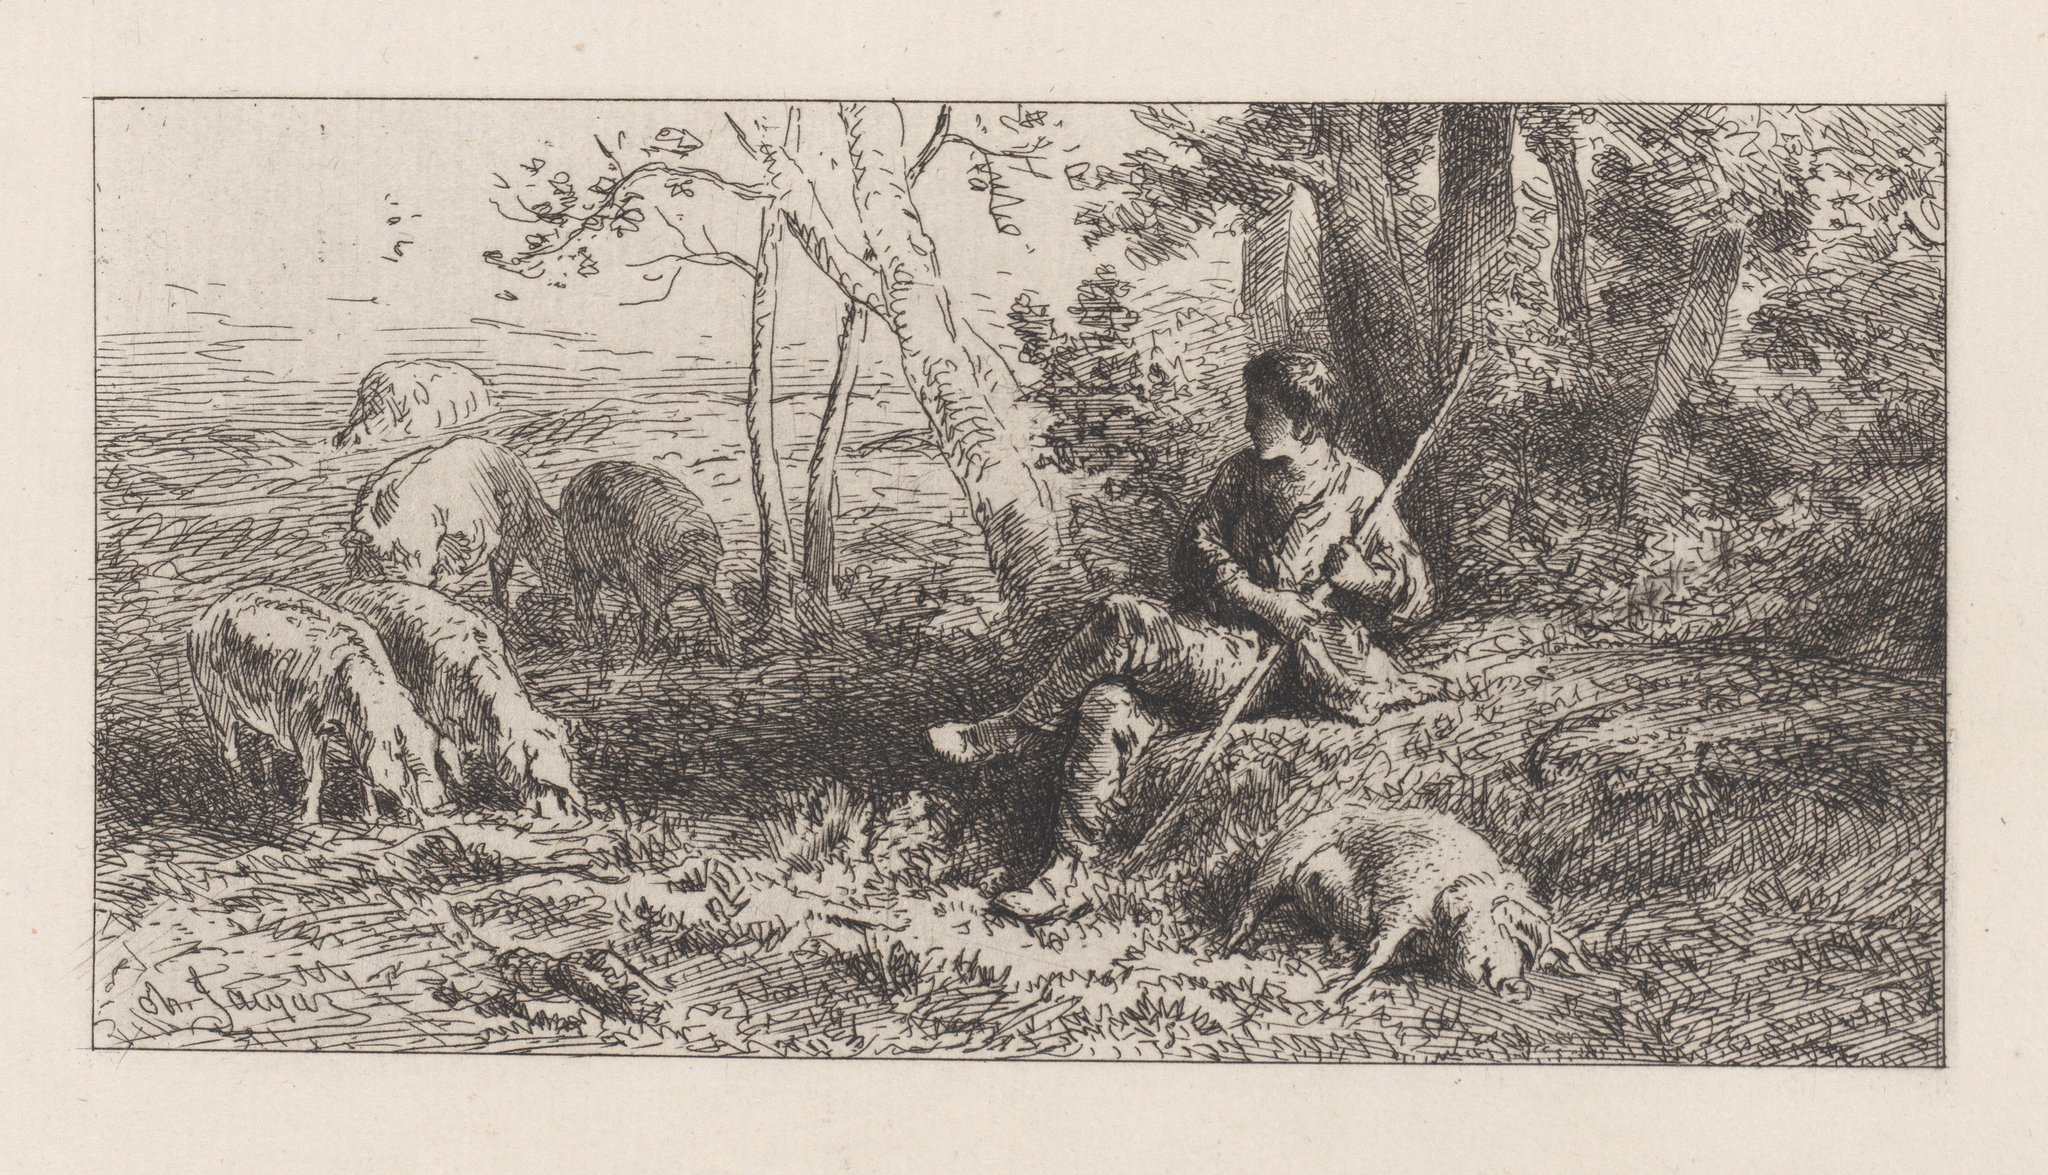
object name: print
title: Small Pig Herd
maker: charles émile jacque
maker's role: artist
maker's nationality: french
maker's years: 1813-1894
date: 1864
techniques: etching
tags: men,pigs